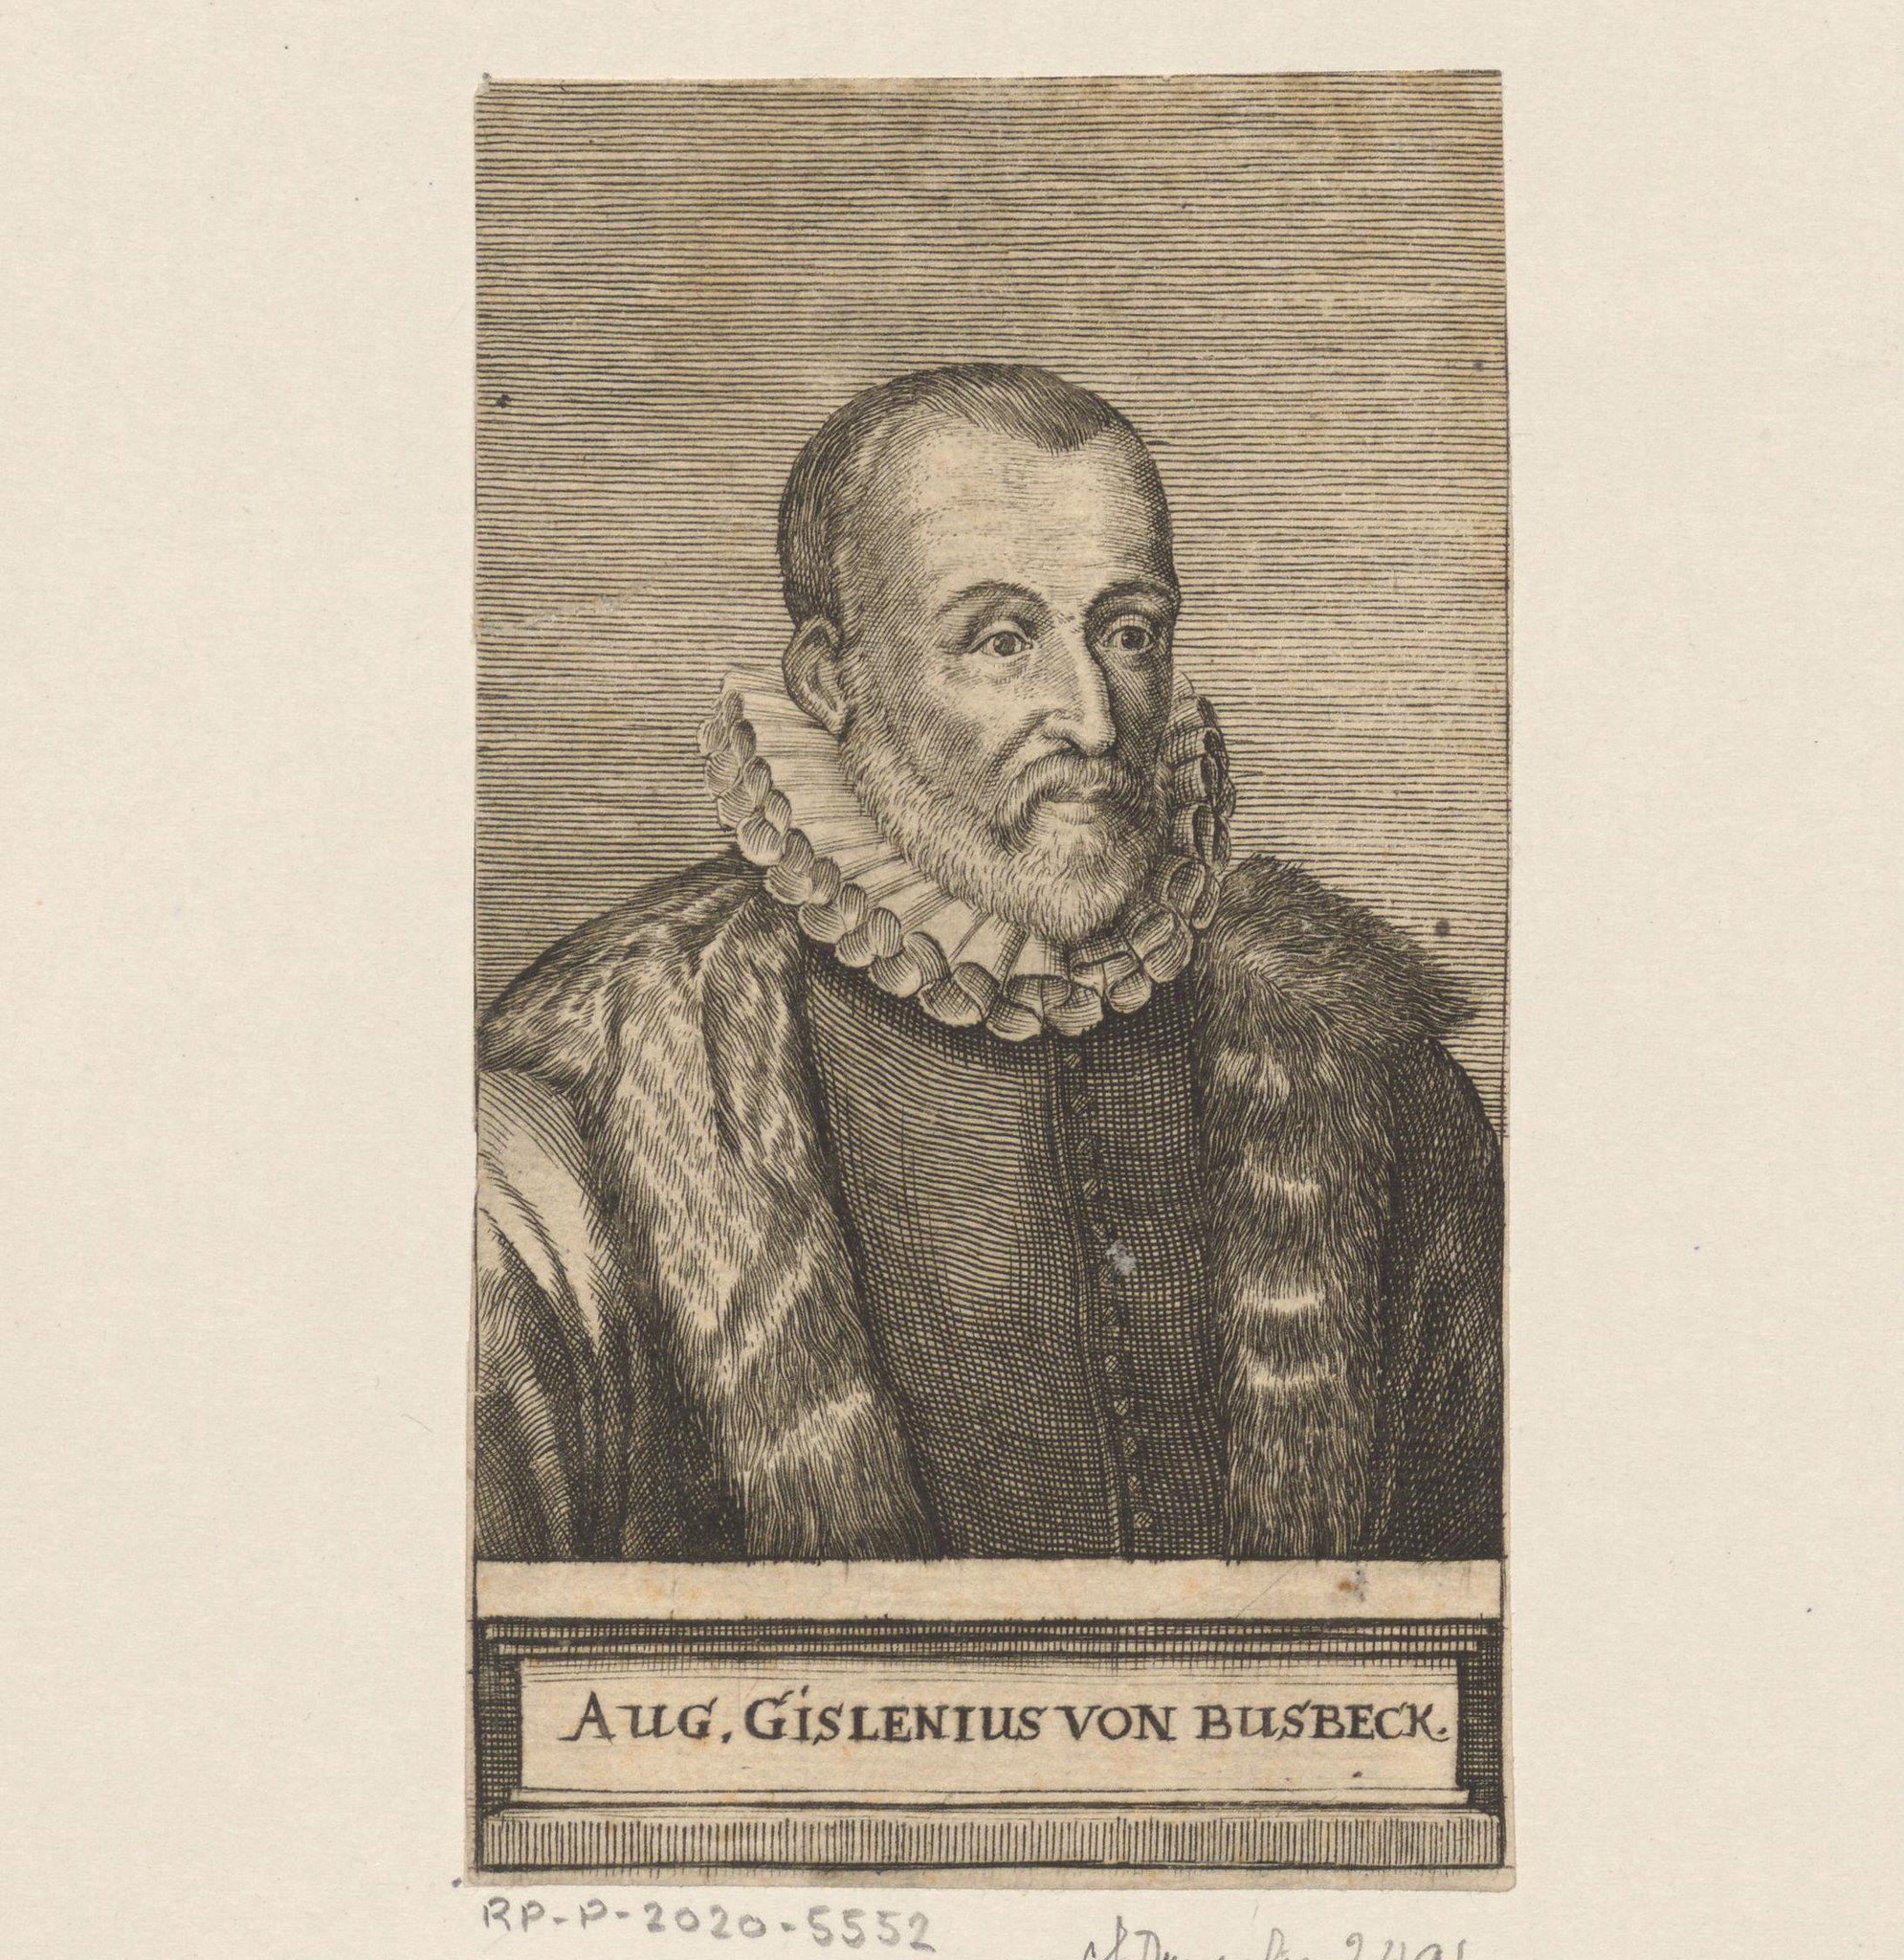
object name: print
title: Portret van Ogier Ghislain de Busbecq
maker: Anonymous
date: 1600-1699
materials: paper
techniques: engraving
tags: official; civil servant; functionary (in general), historical persons